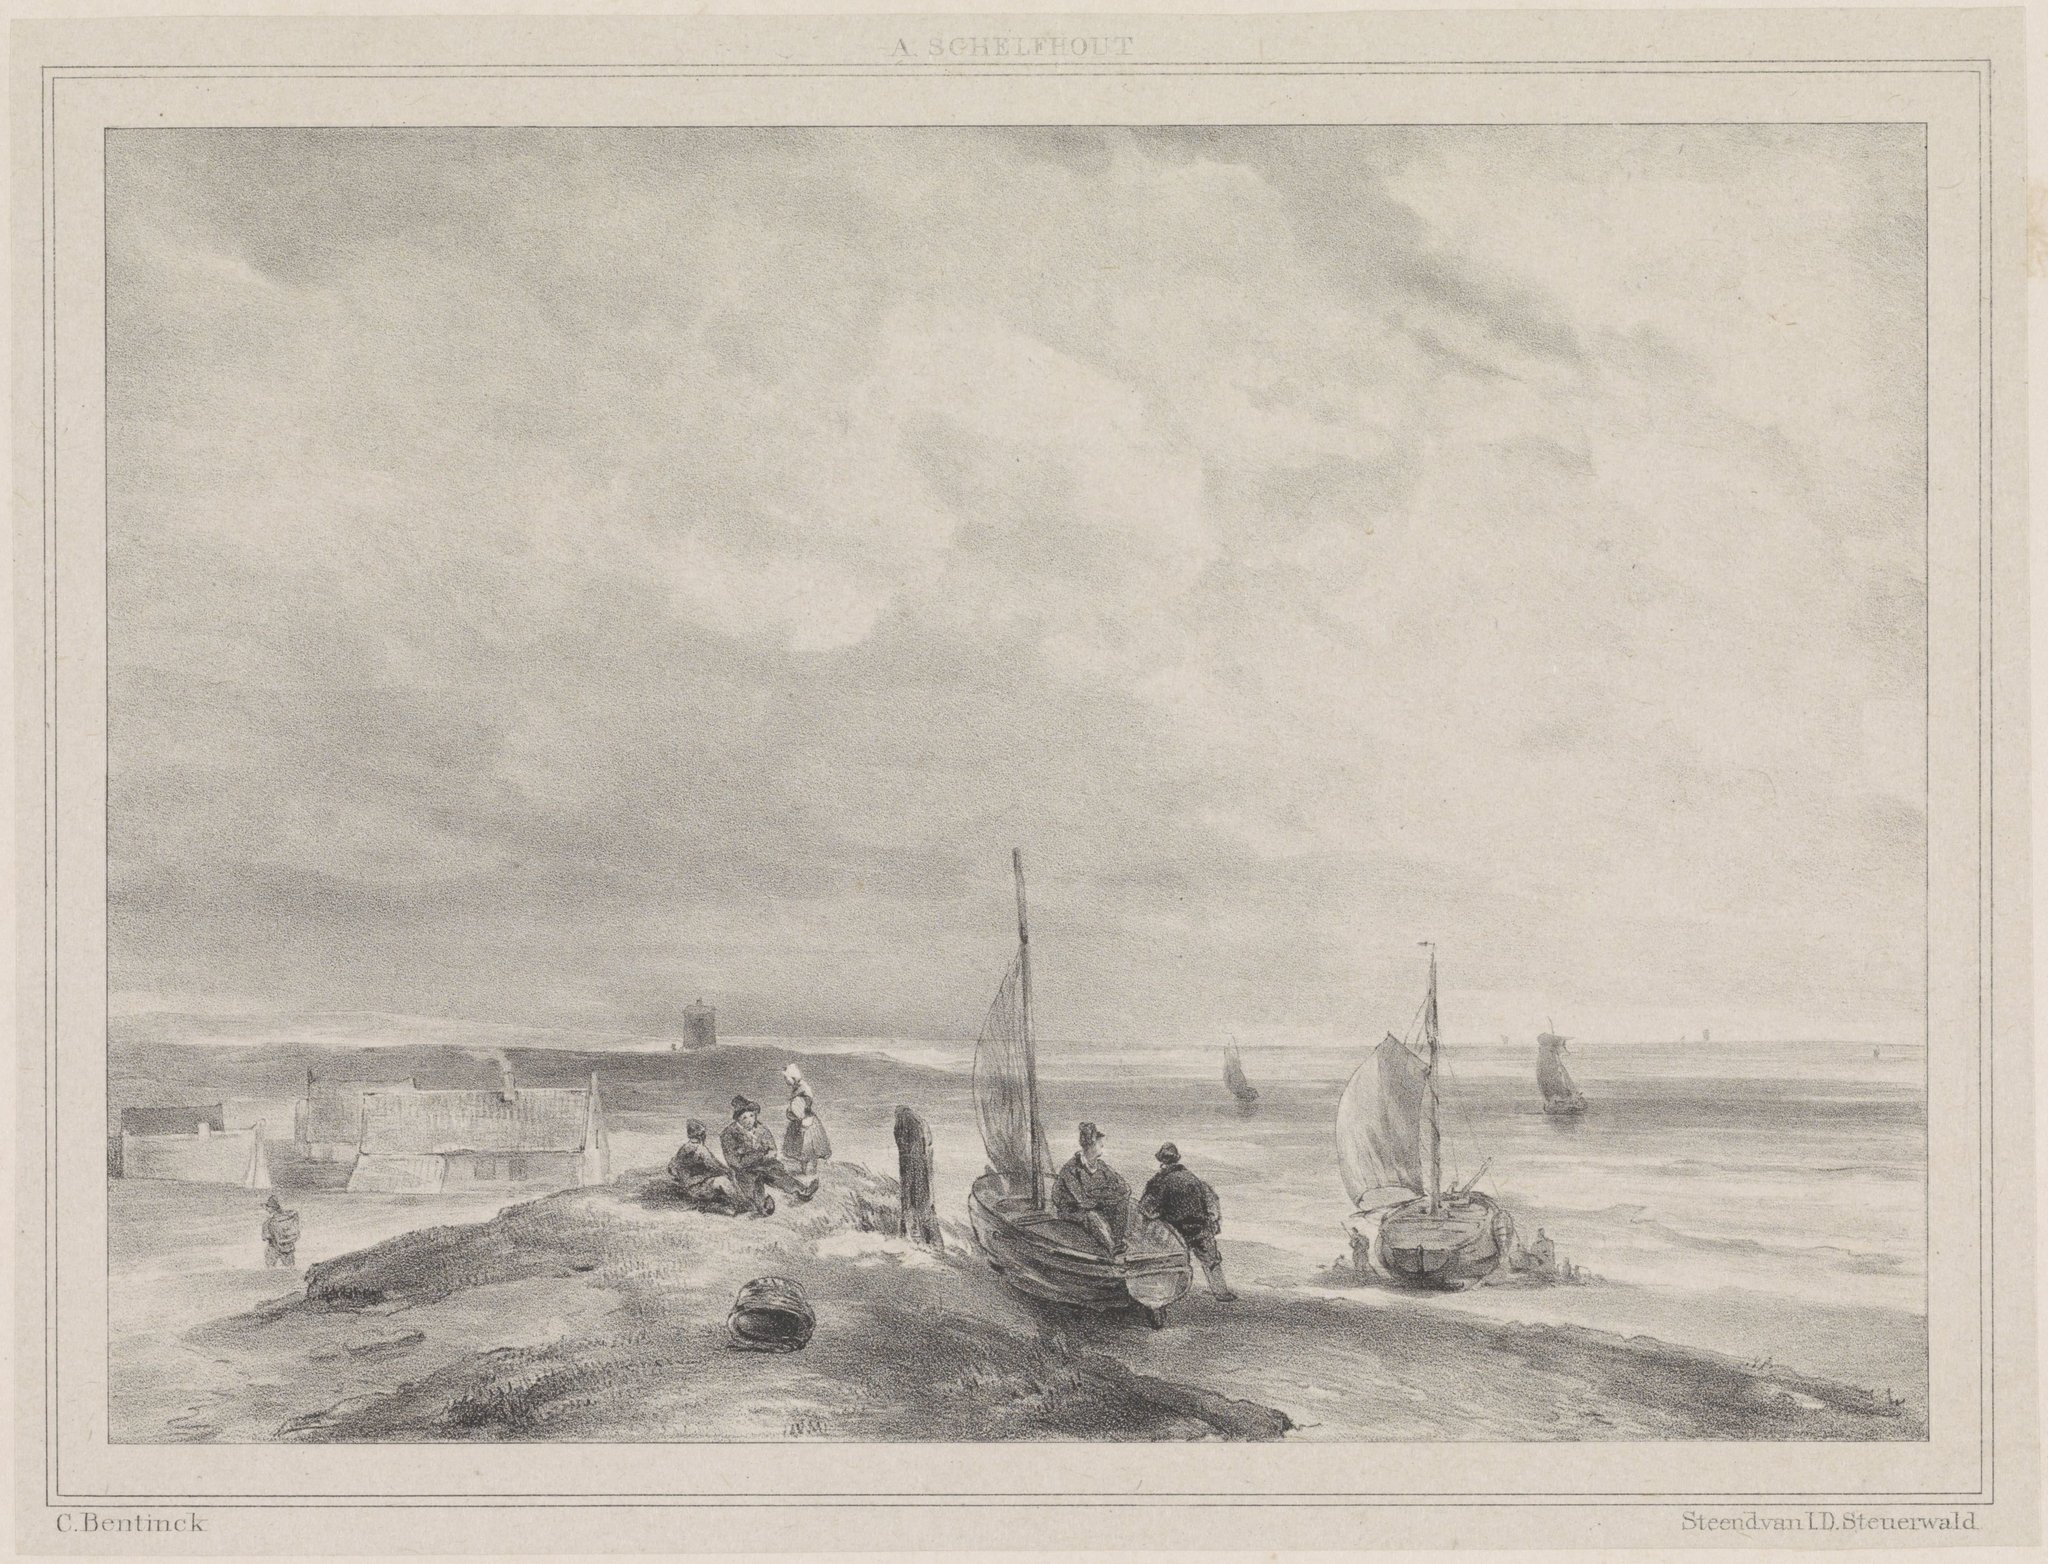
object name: print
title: Strand met vissers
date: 1824-1849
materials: paper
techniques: lithograph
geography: netherlands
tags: ships (in general), beach, sea and coastal fishery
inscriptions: collector's mark: Lugt 2228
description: Op het strand liggen enkele boten op het droge. Daarbij zitten mannen en een vrouw. In de verte staan wat huizen. Op het water varen een aantal schepen met gestreken zeilen. Naar een schilderij van Andreas Schelfhout.